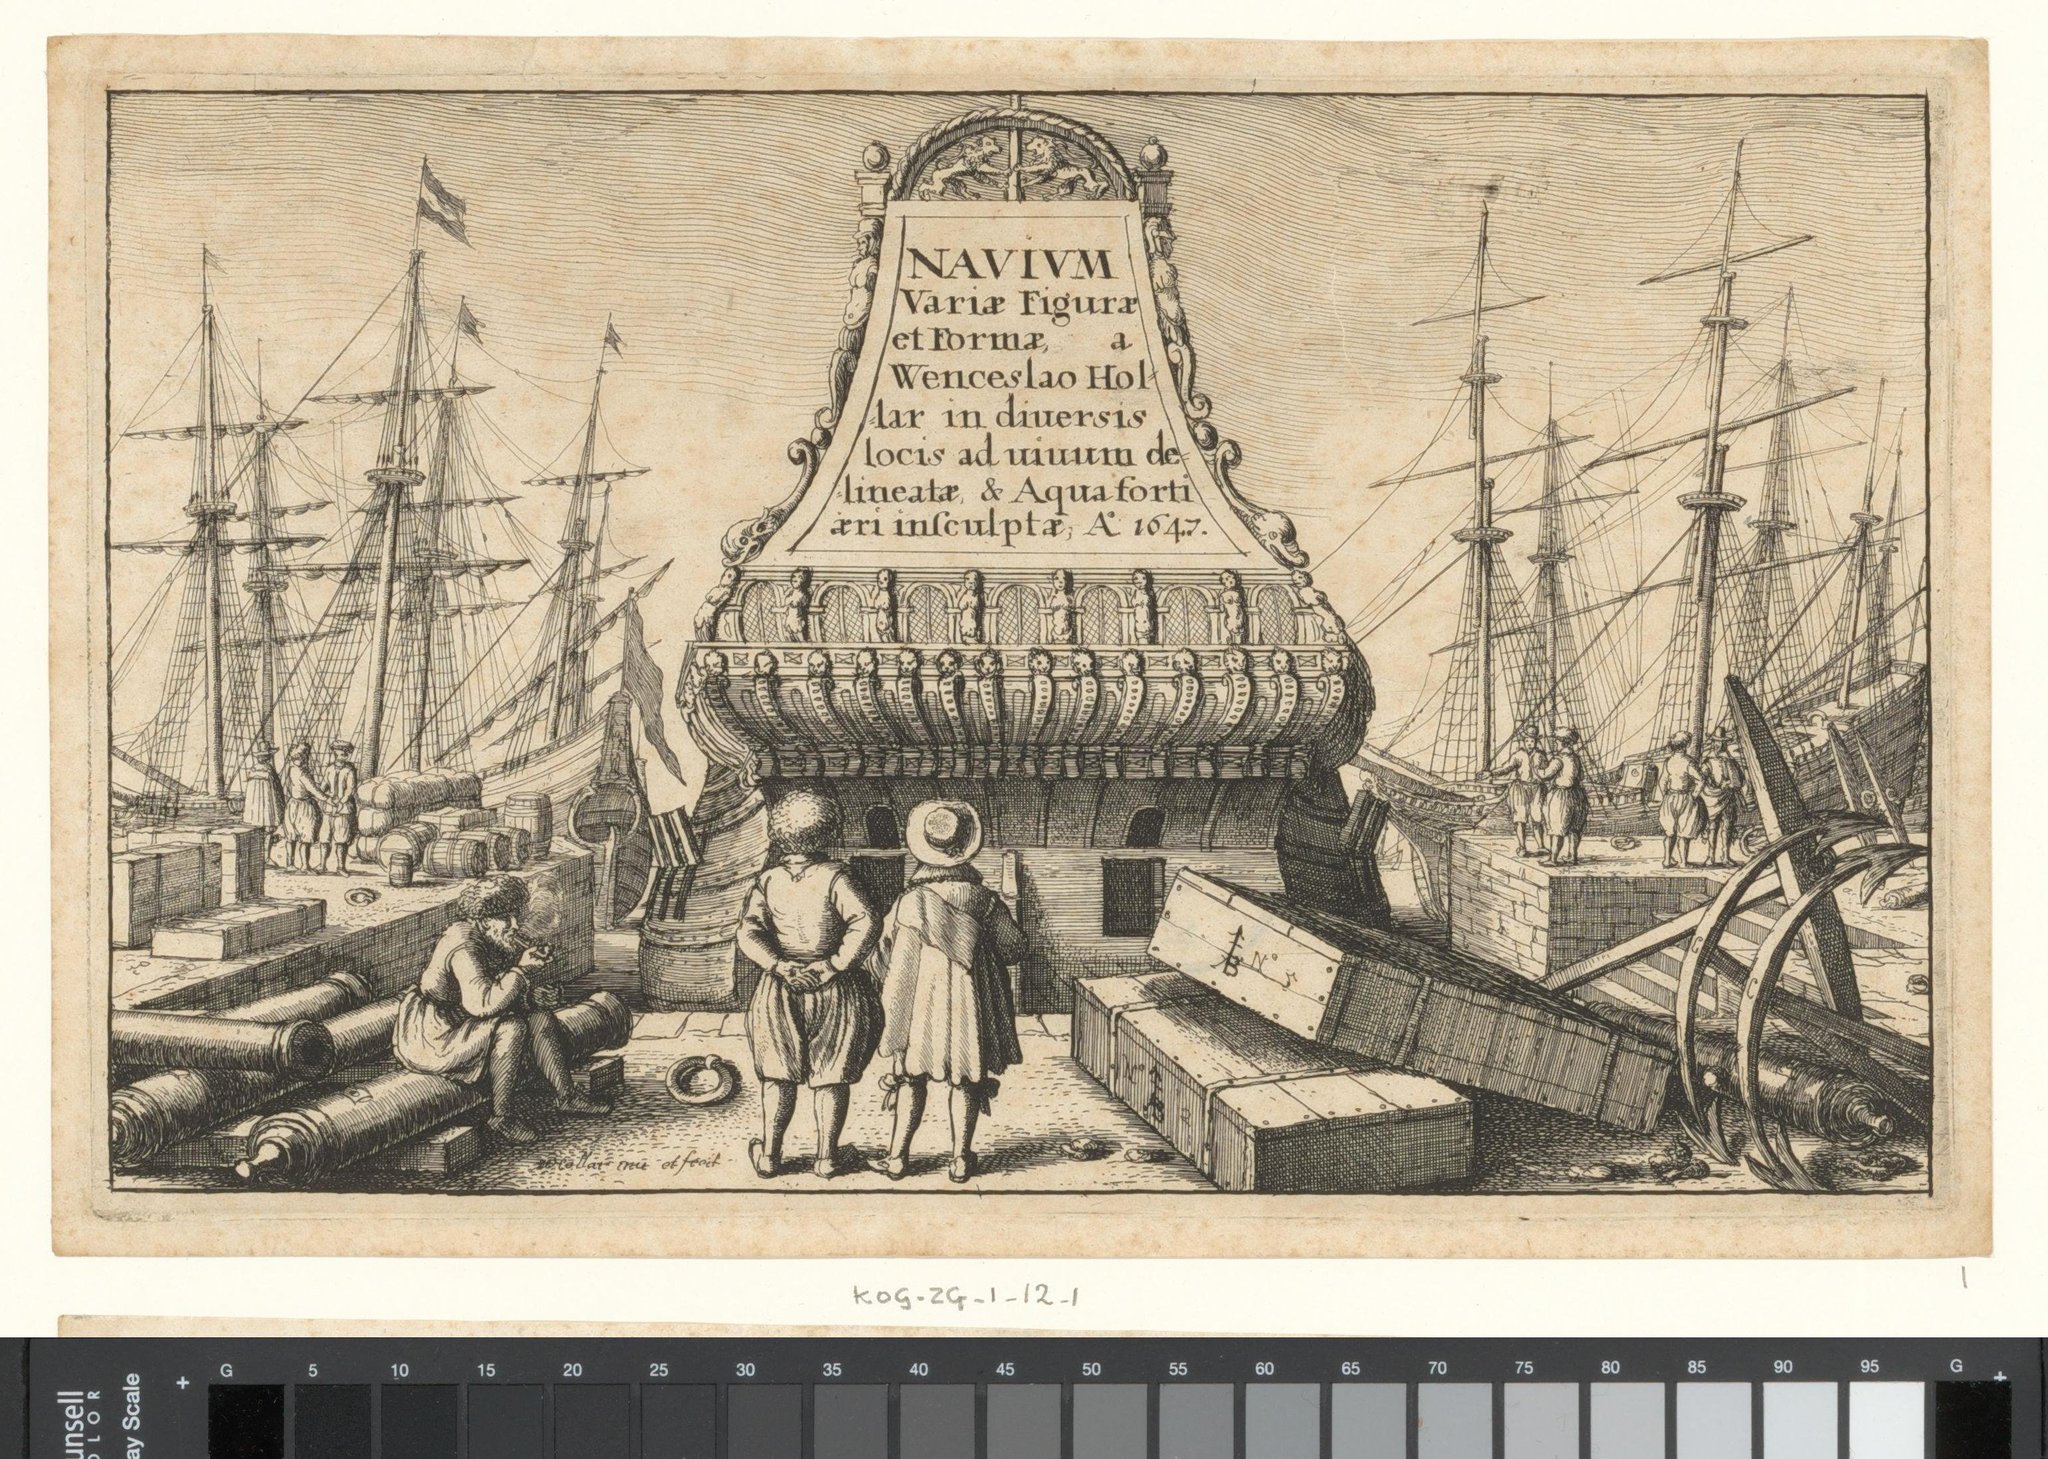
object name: print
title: Schepen in een haven met goederen op de kade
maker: wenceslaus hollar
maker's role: draughtsman, print maker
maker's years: 1607-1677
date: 1647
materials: paper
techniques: etching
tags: sailing-ship, sailing-boat, pier, quay, wharf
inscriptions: collector's mark: Lugt 1641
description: Onderwerpsrubrieken binnen de Atlas Zeden en Gewoonten: Handel, Nijverheid en Verkeer, Scheepsbouw.